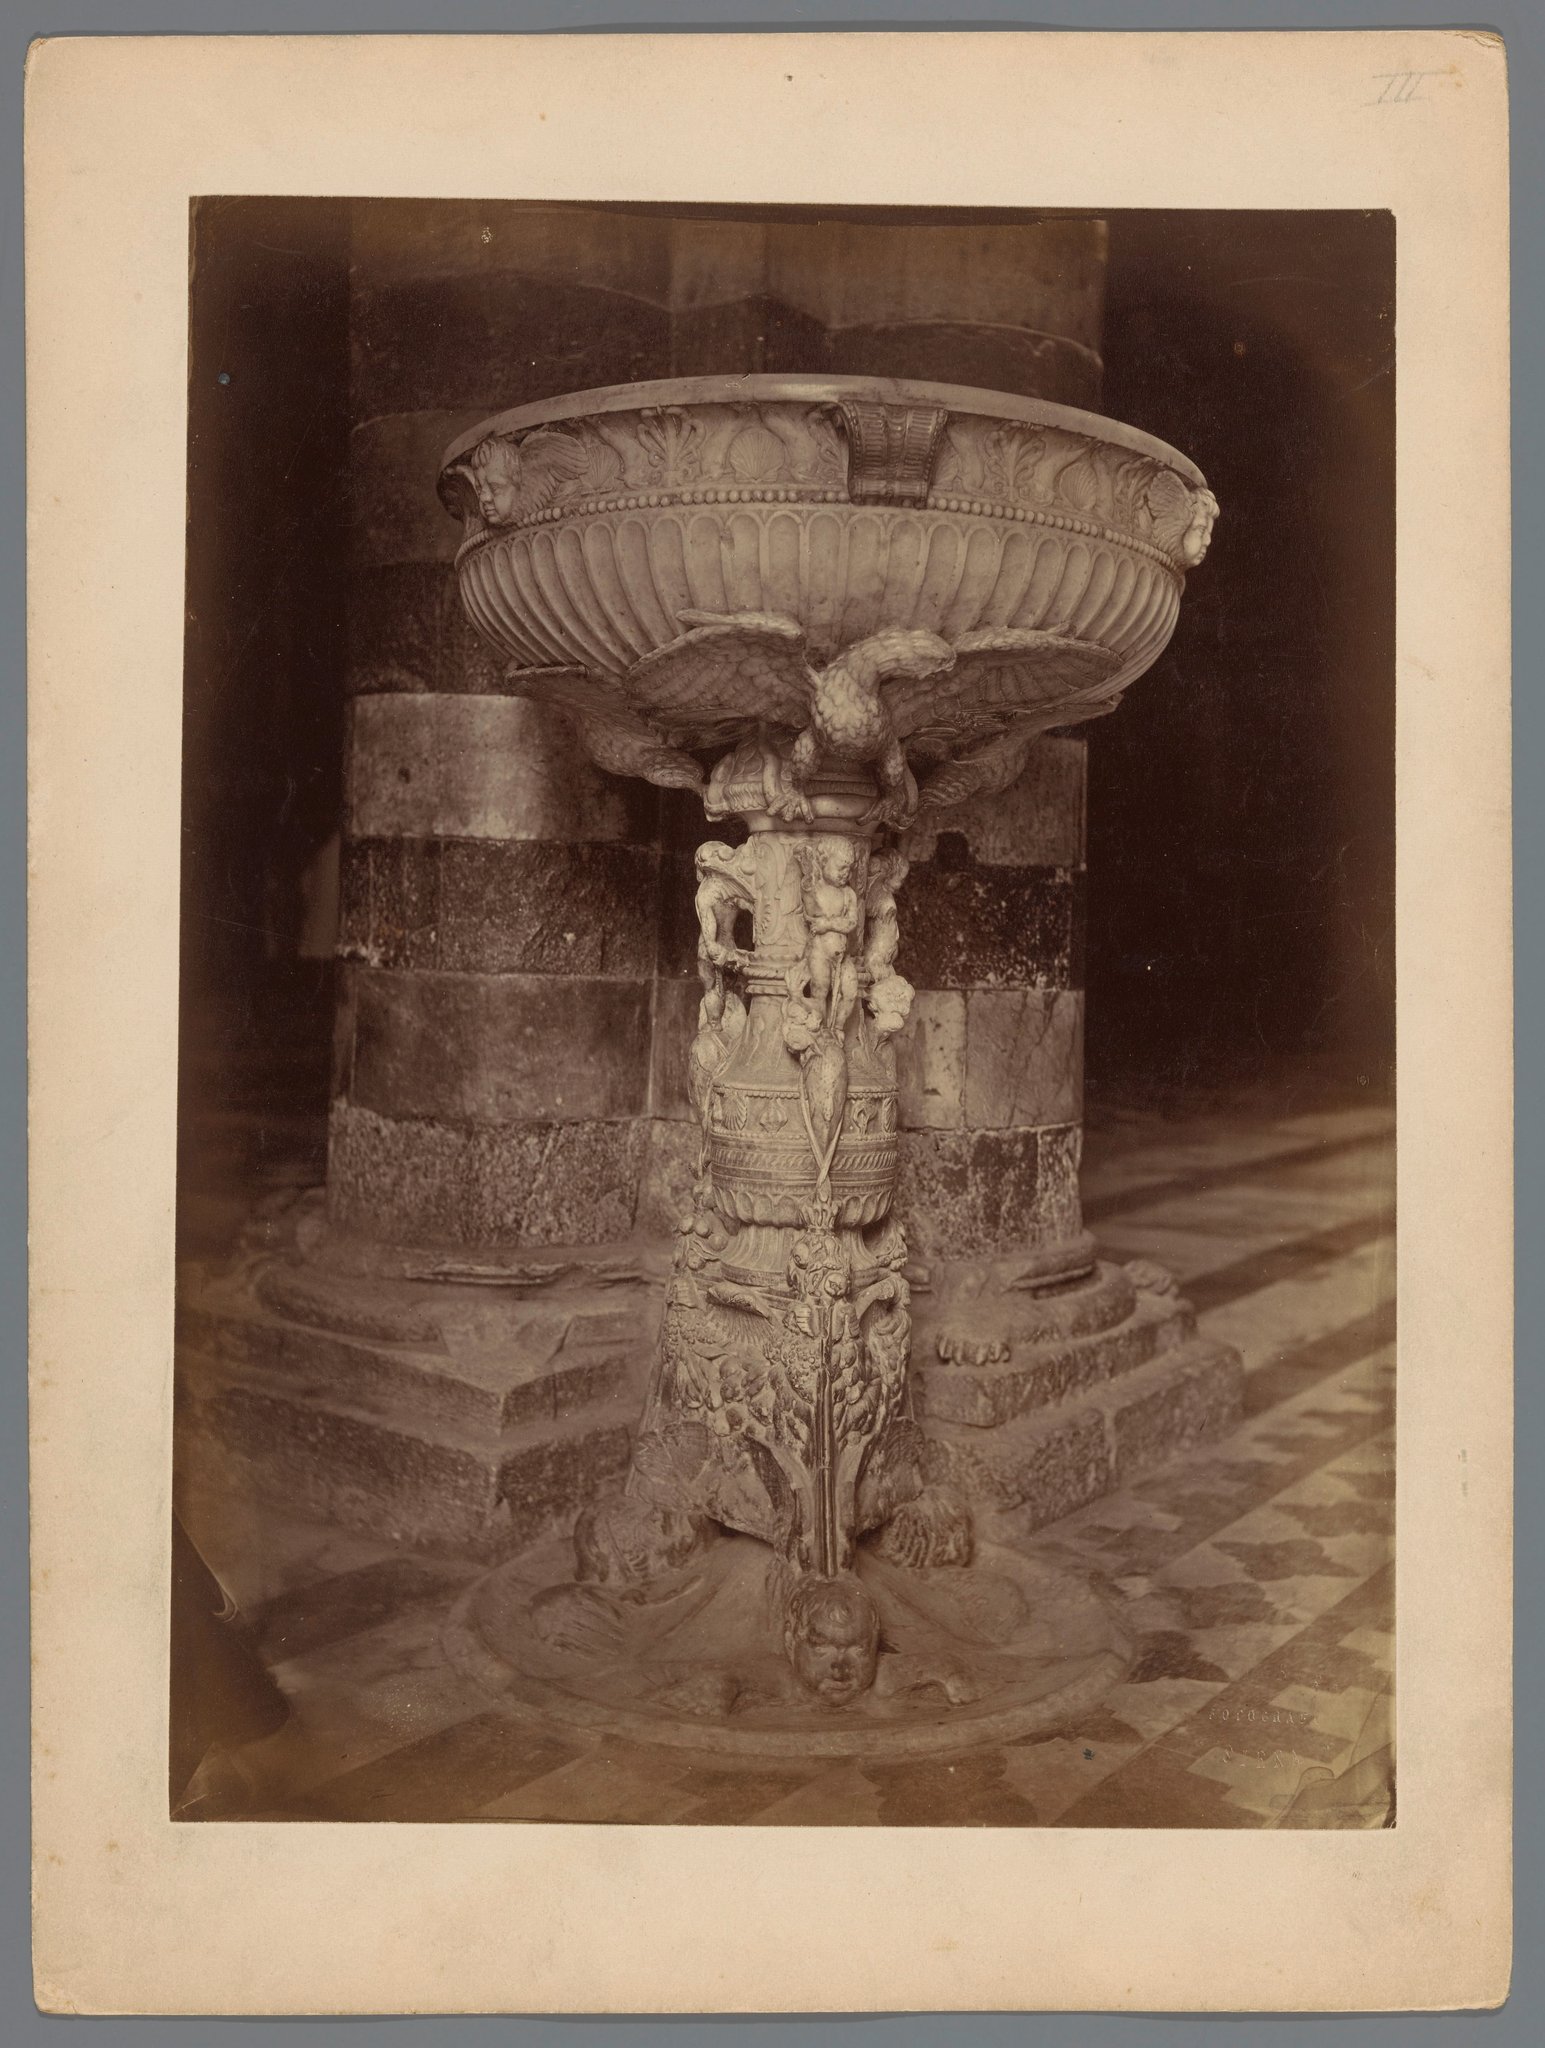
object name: photograph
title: Wijwatervat in de Dom van Siena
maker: paolo lombardi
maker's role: fotograaf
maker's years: 1827-1890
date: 1875-1900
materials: cardboard, photographic support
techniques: albumen print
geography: siena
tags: cherubs, i.e. children's heads with wings, predatory birds: eagle, interior of church, holy water font, cupids: 'amores', 'amoretti', 'putti'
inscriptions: collector's mark: Lugt 3937, name: ‘P. LOMBARDI FOTOGRAFO SIENA’, inscription: ‘Stijlkast 16’